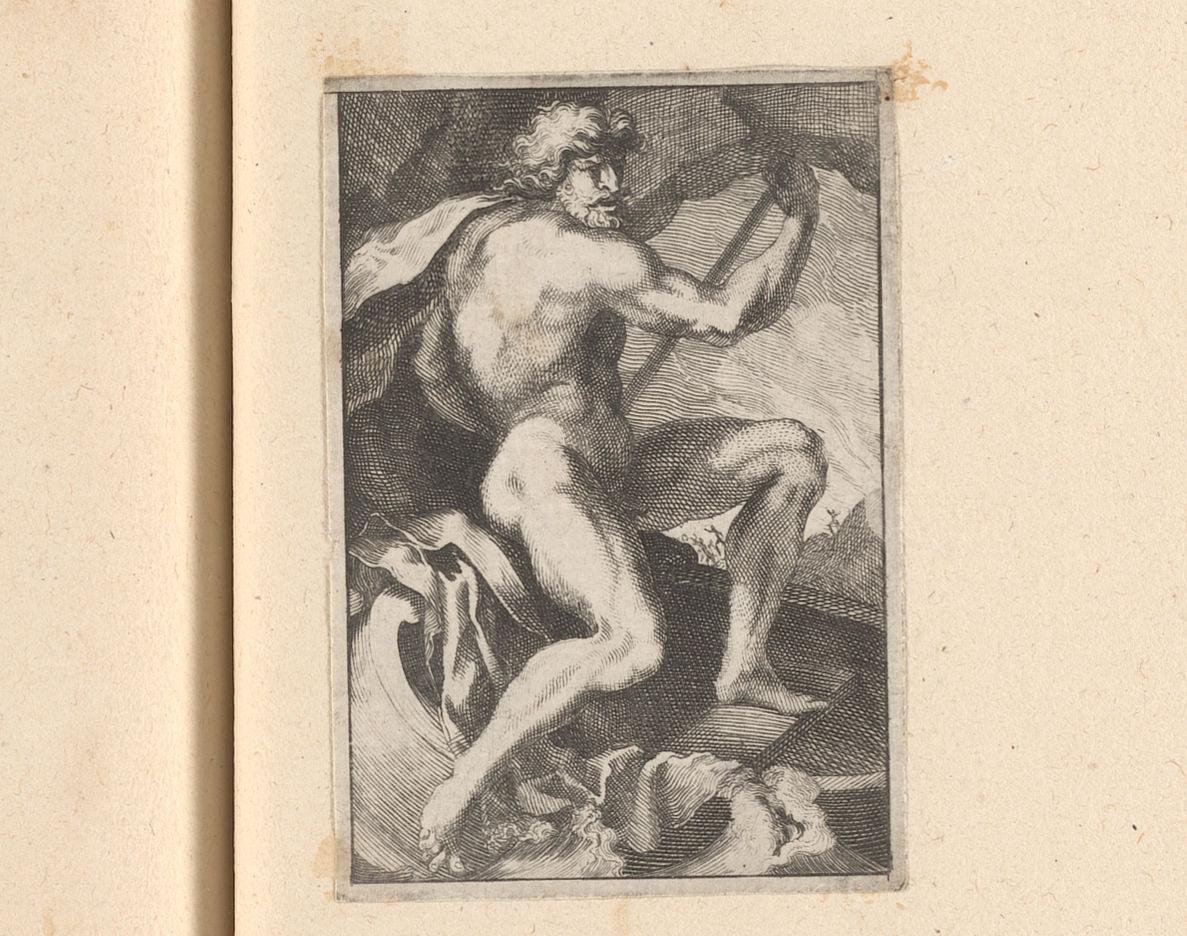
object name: print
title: Figures d'Academie pour apprendre à désiner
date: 1665-1673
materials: paper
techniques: etching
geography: paris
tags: model-books ~ implements of painter, charon, the ferryman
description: Maakt deel uit van een 32-delige serie met tekenvoorbeelden van goden en helden uit de klassieke oudheid. Een eerste editie werd in 1673 uitgegeven en een tweede in 1684 door Nicolas Langlois.